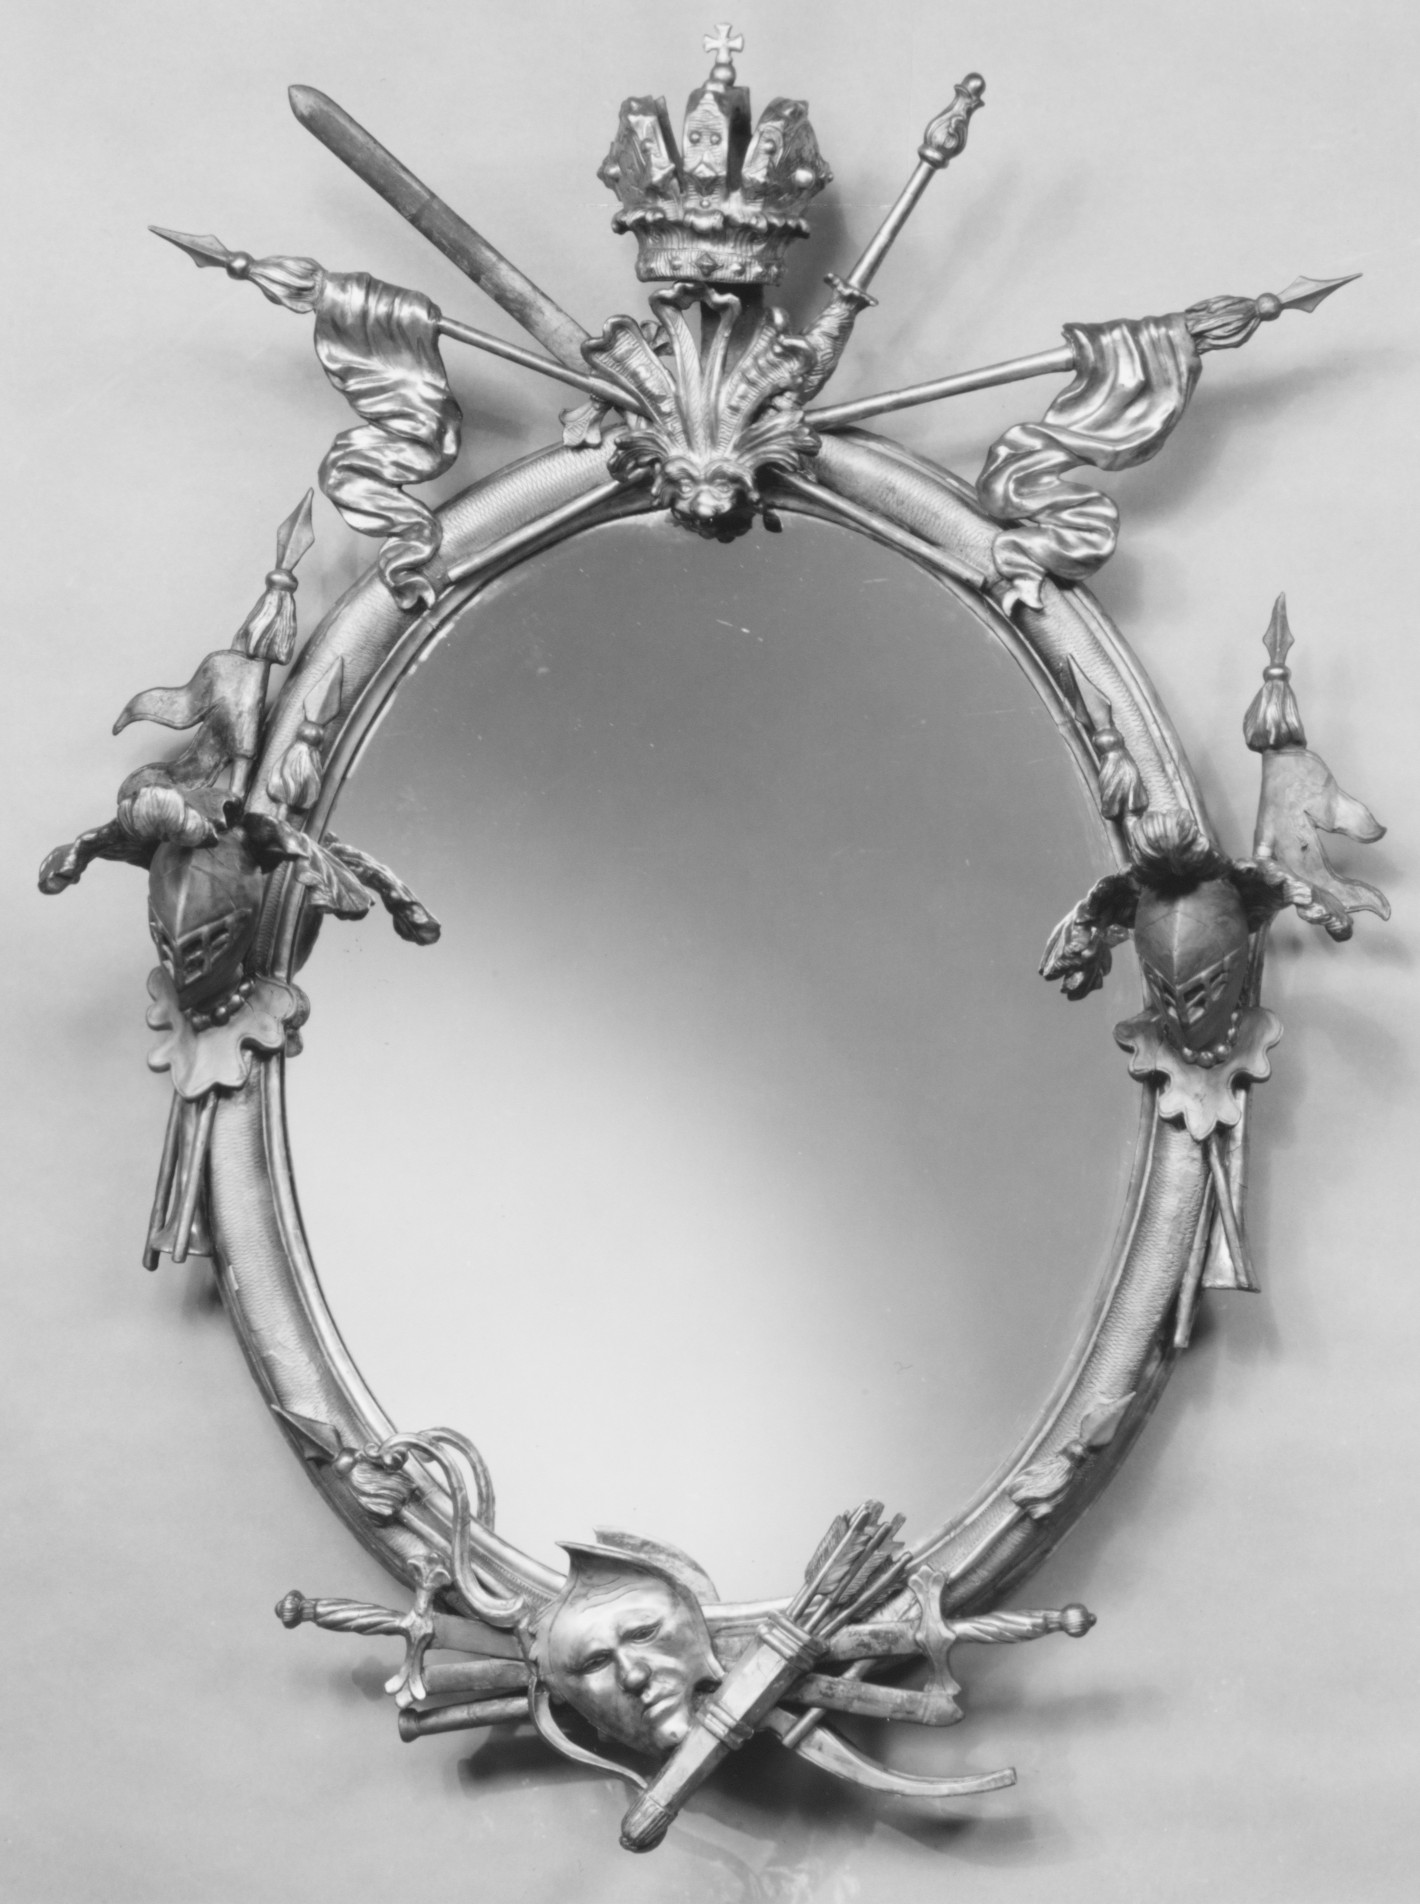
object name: frame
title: Pair of picture frames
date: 1734-1766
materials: gilt, paint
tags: masks,bow and arrow,swords,flags